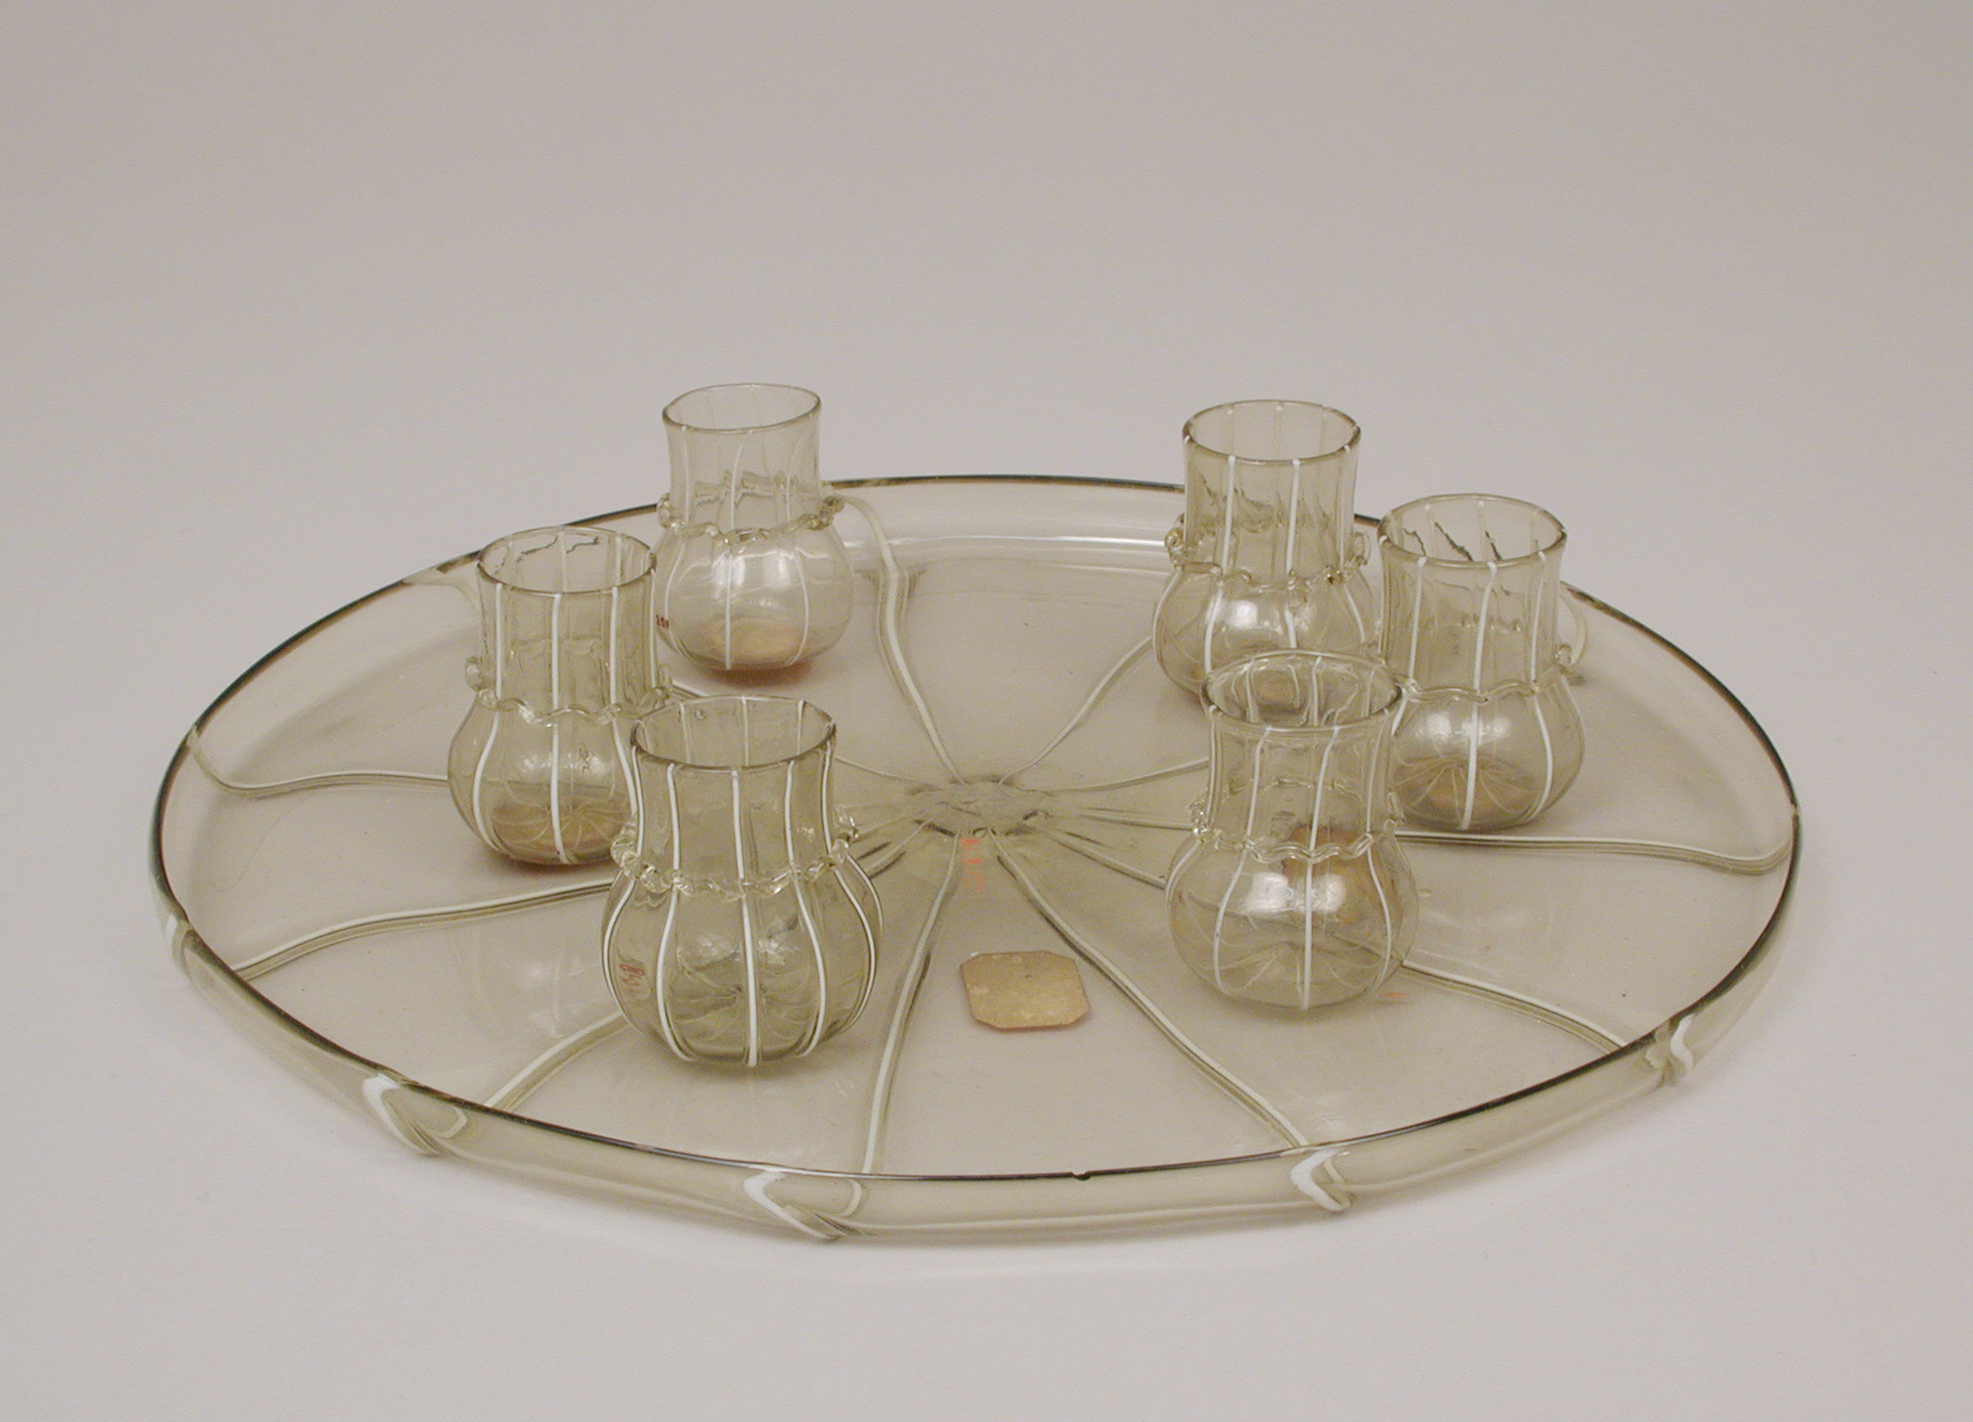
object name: schnapps glass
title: Schnapps glass (one of six)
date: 1801-1900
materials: glass